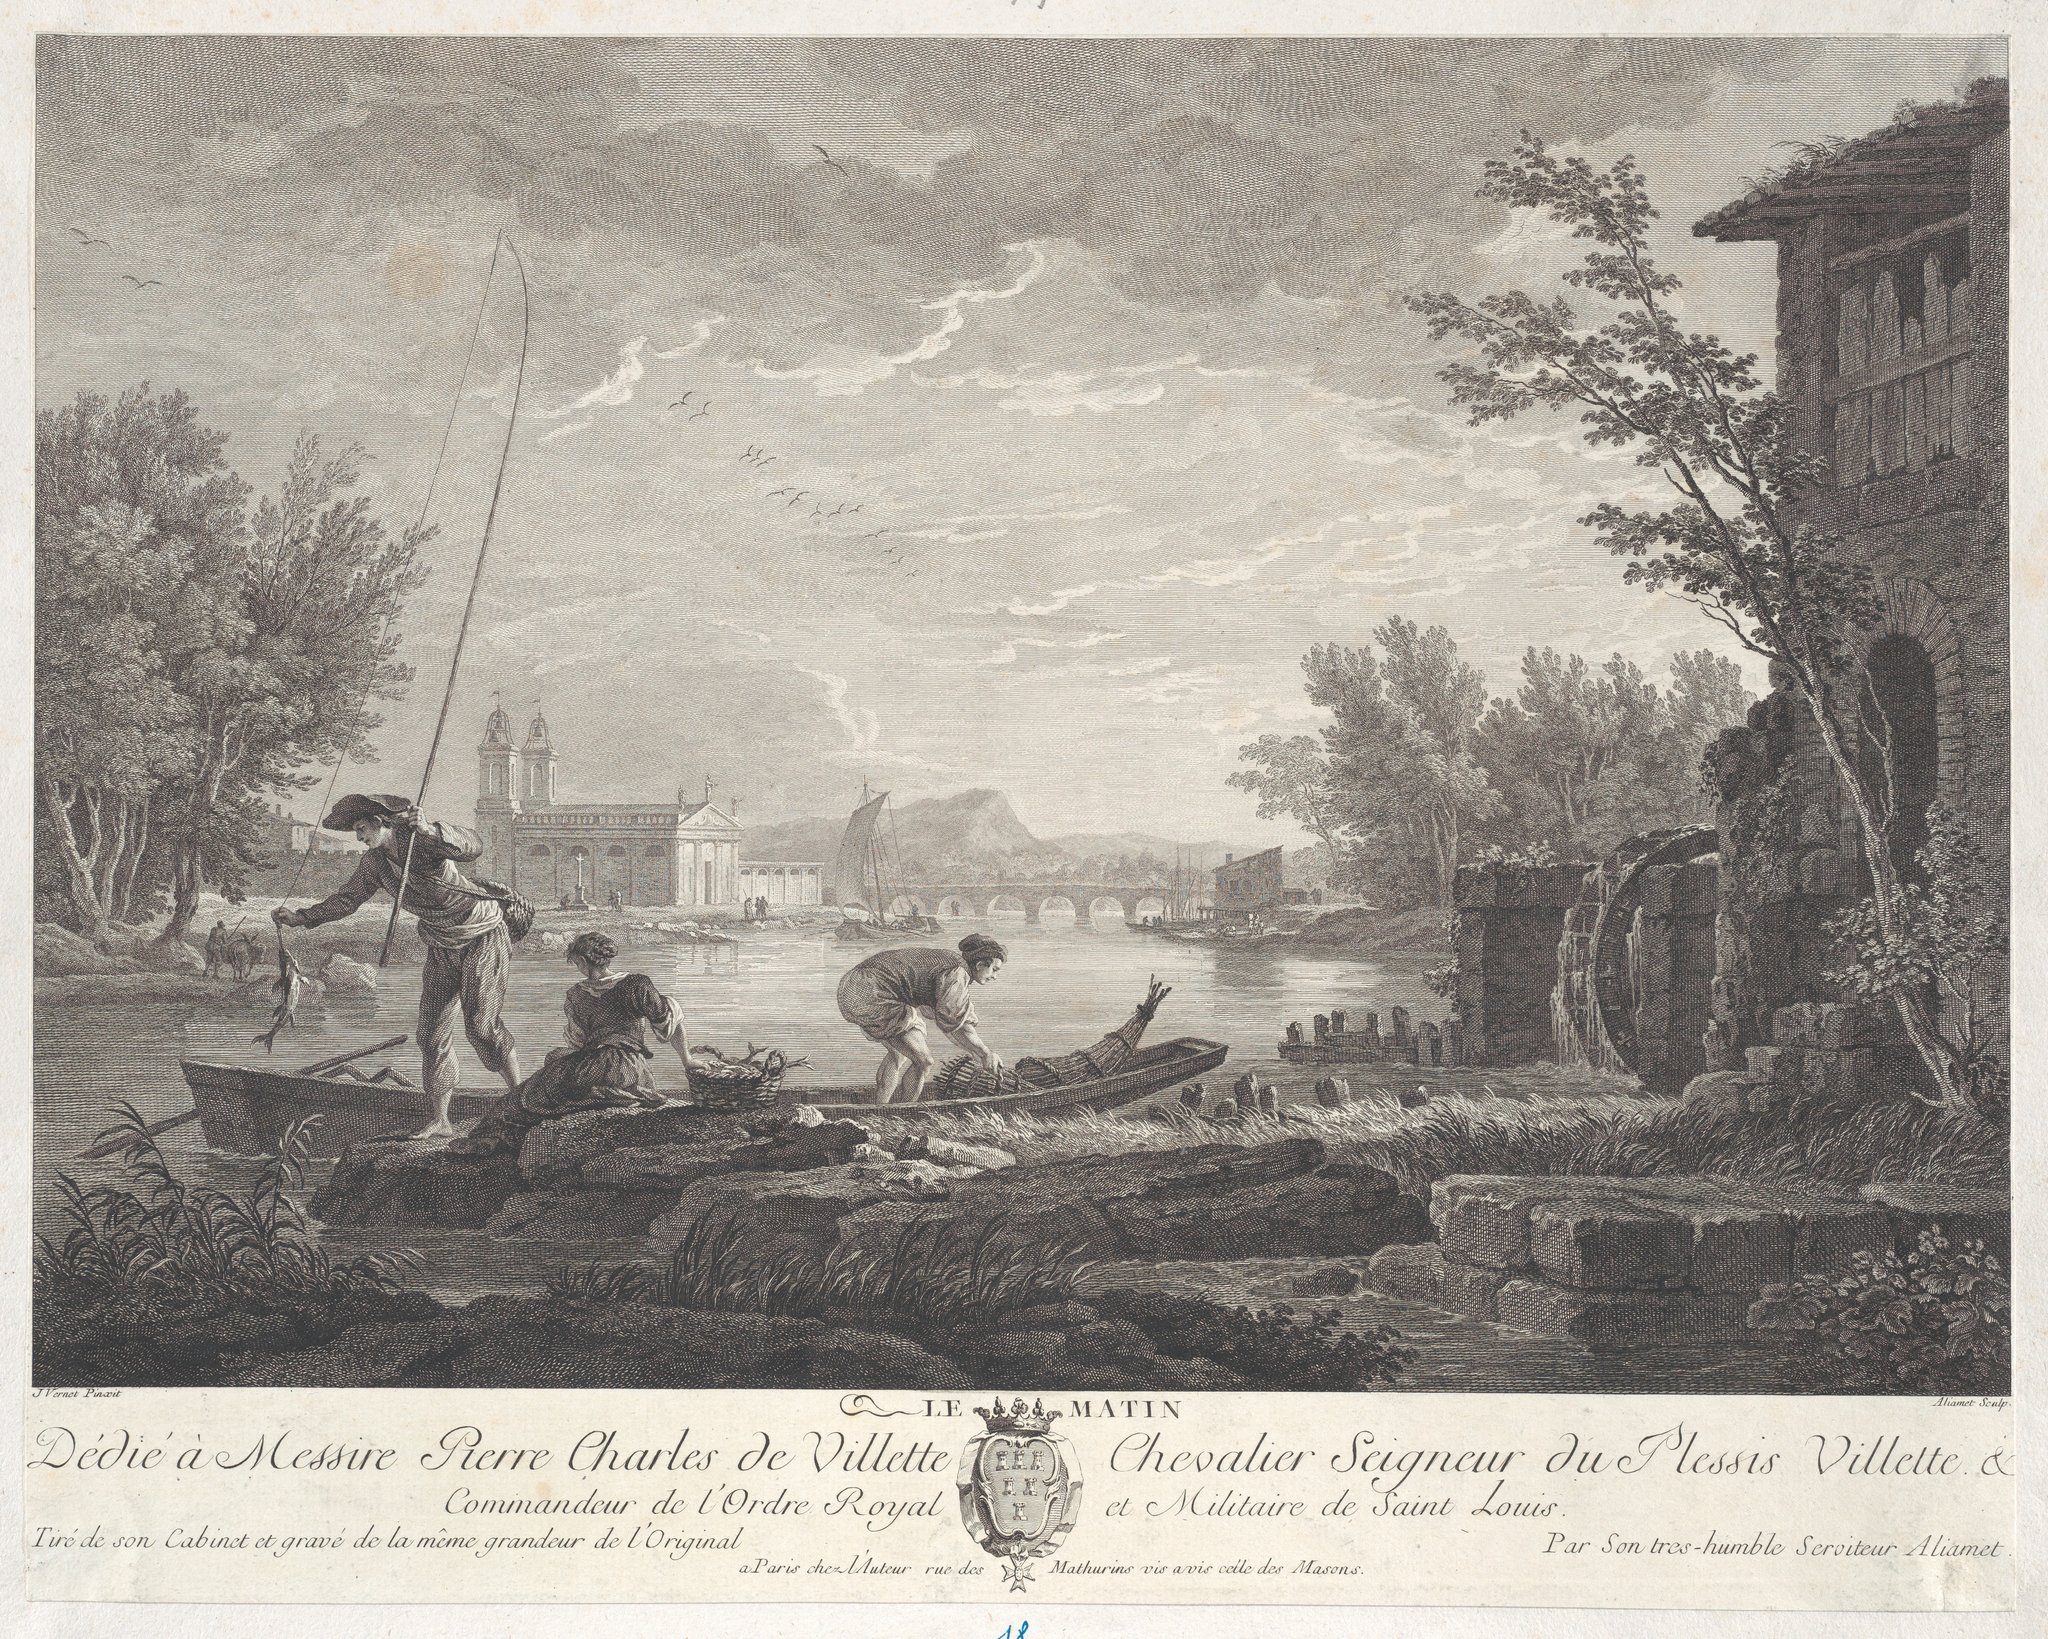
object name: print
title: The Morning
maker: joseph vernet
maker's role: artist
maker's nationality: french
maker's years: 1714-1789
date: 1765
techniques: engraving